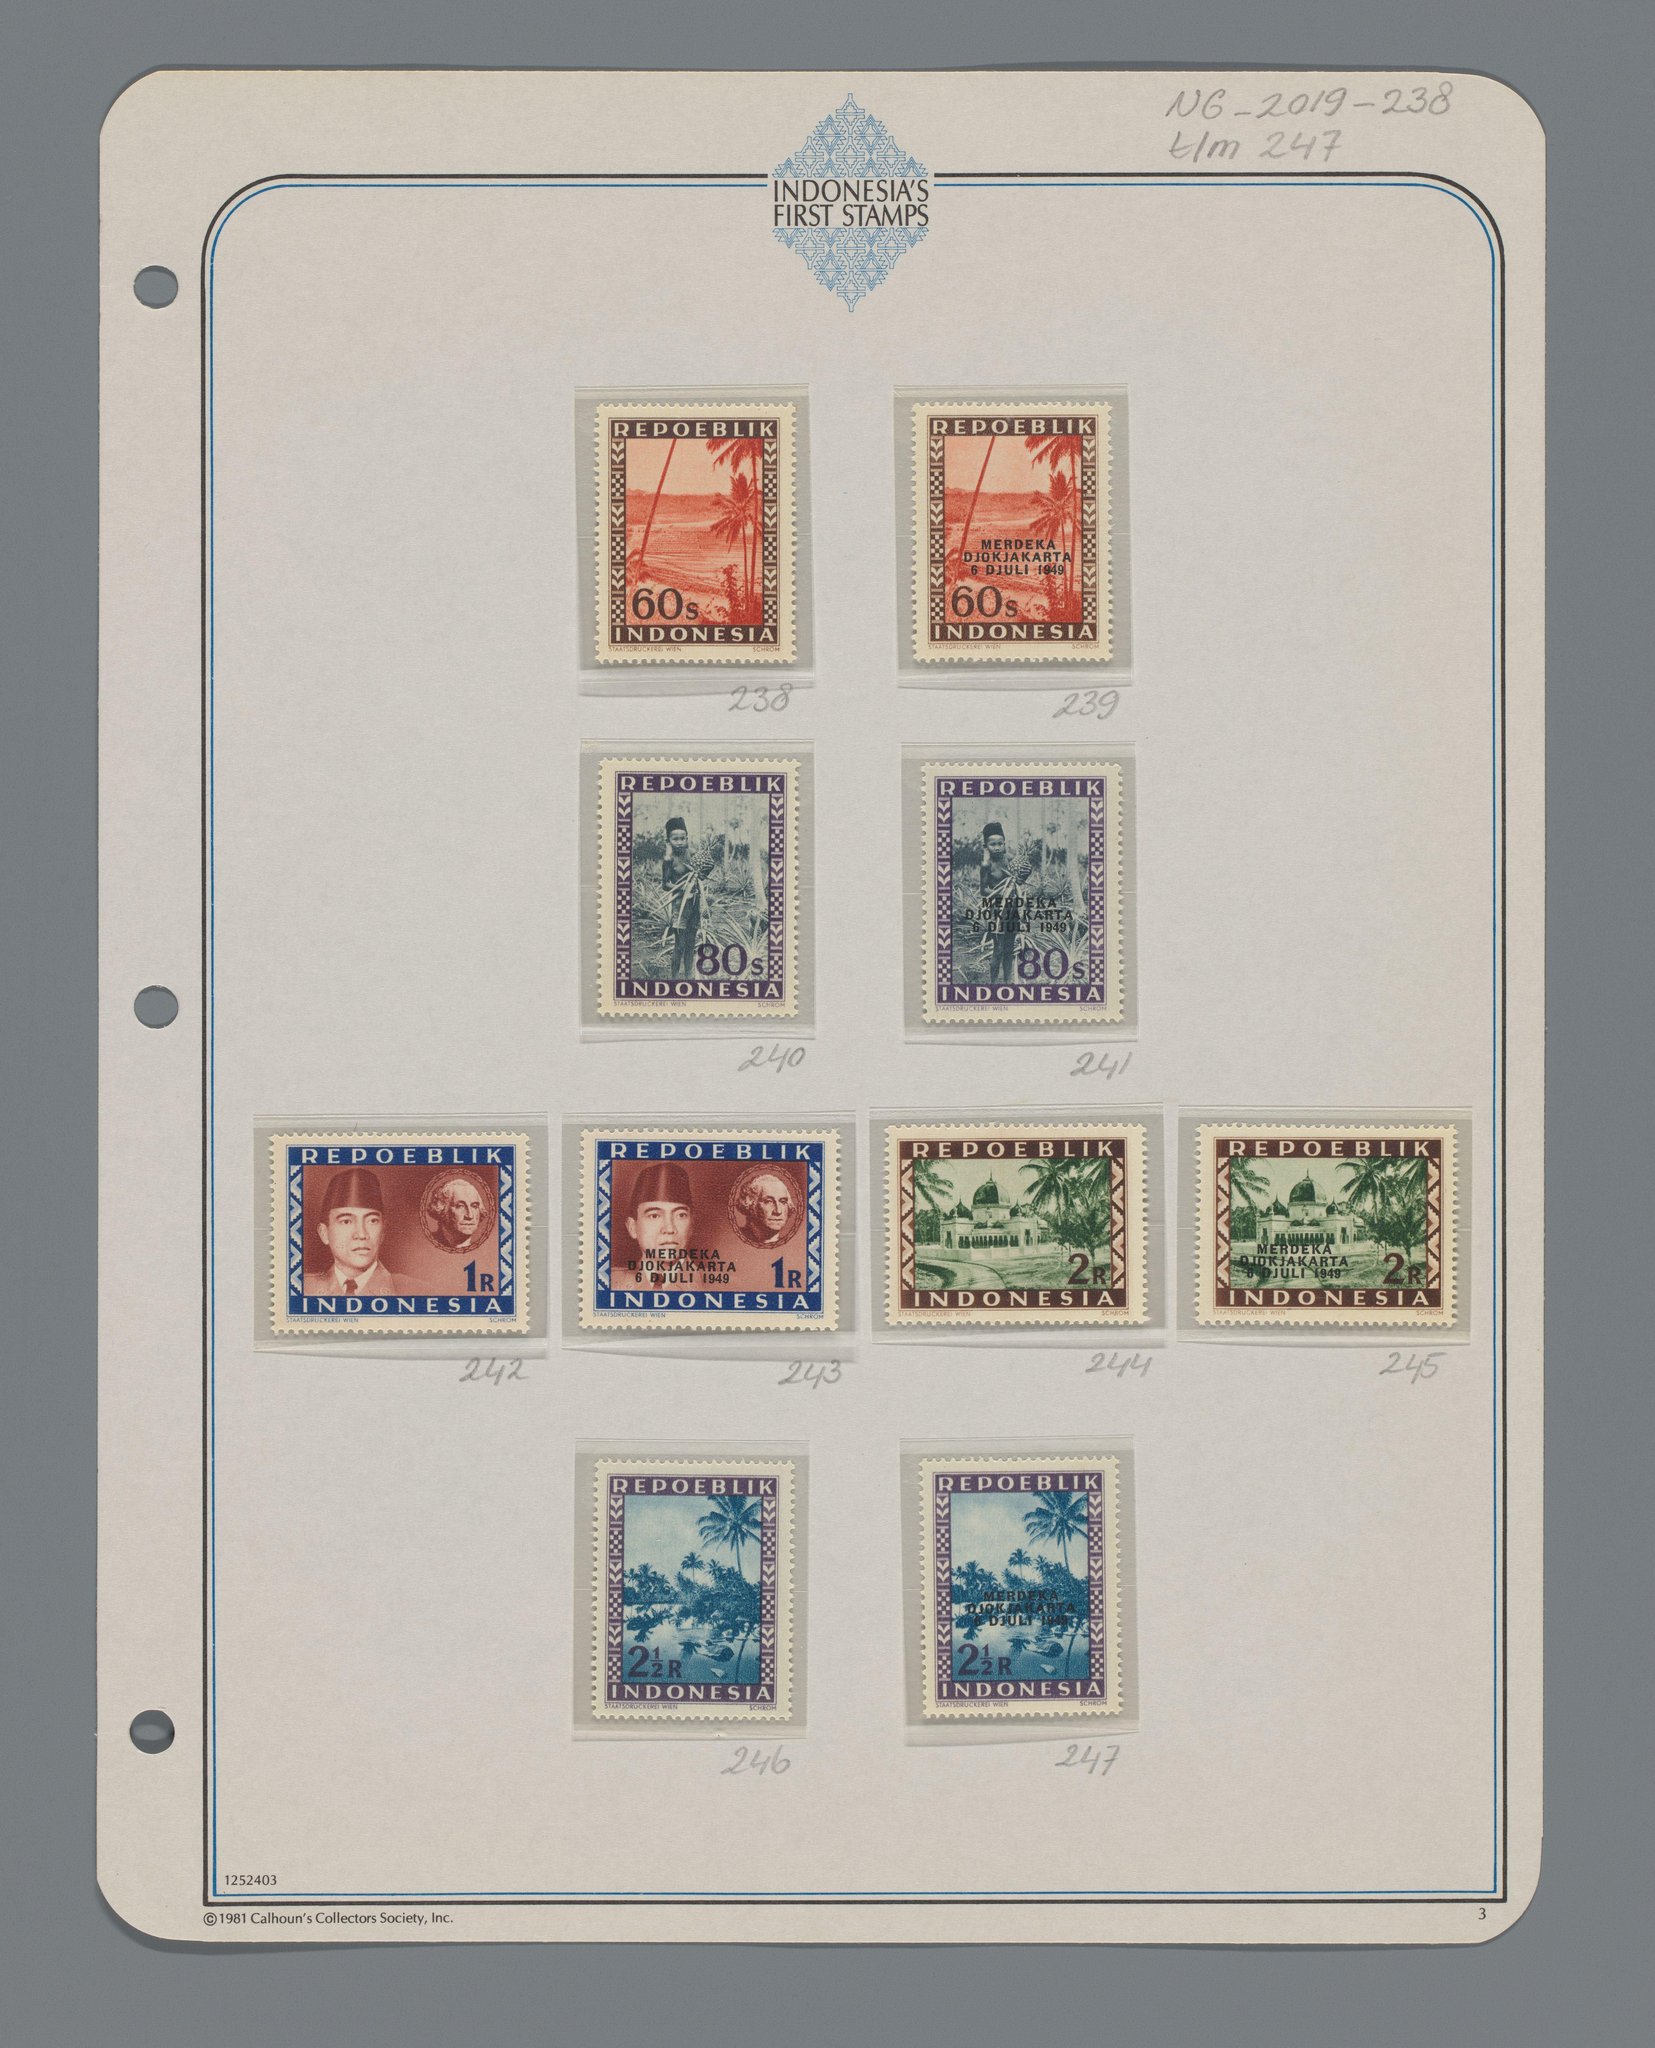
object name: postage stamp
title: Postzegel Republik Indonesia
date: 1949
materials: paper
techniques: photoaquatint, engraving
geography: philadelphia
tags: indonesia